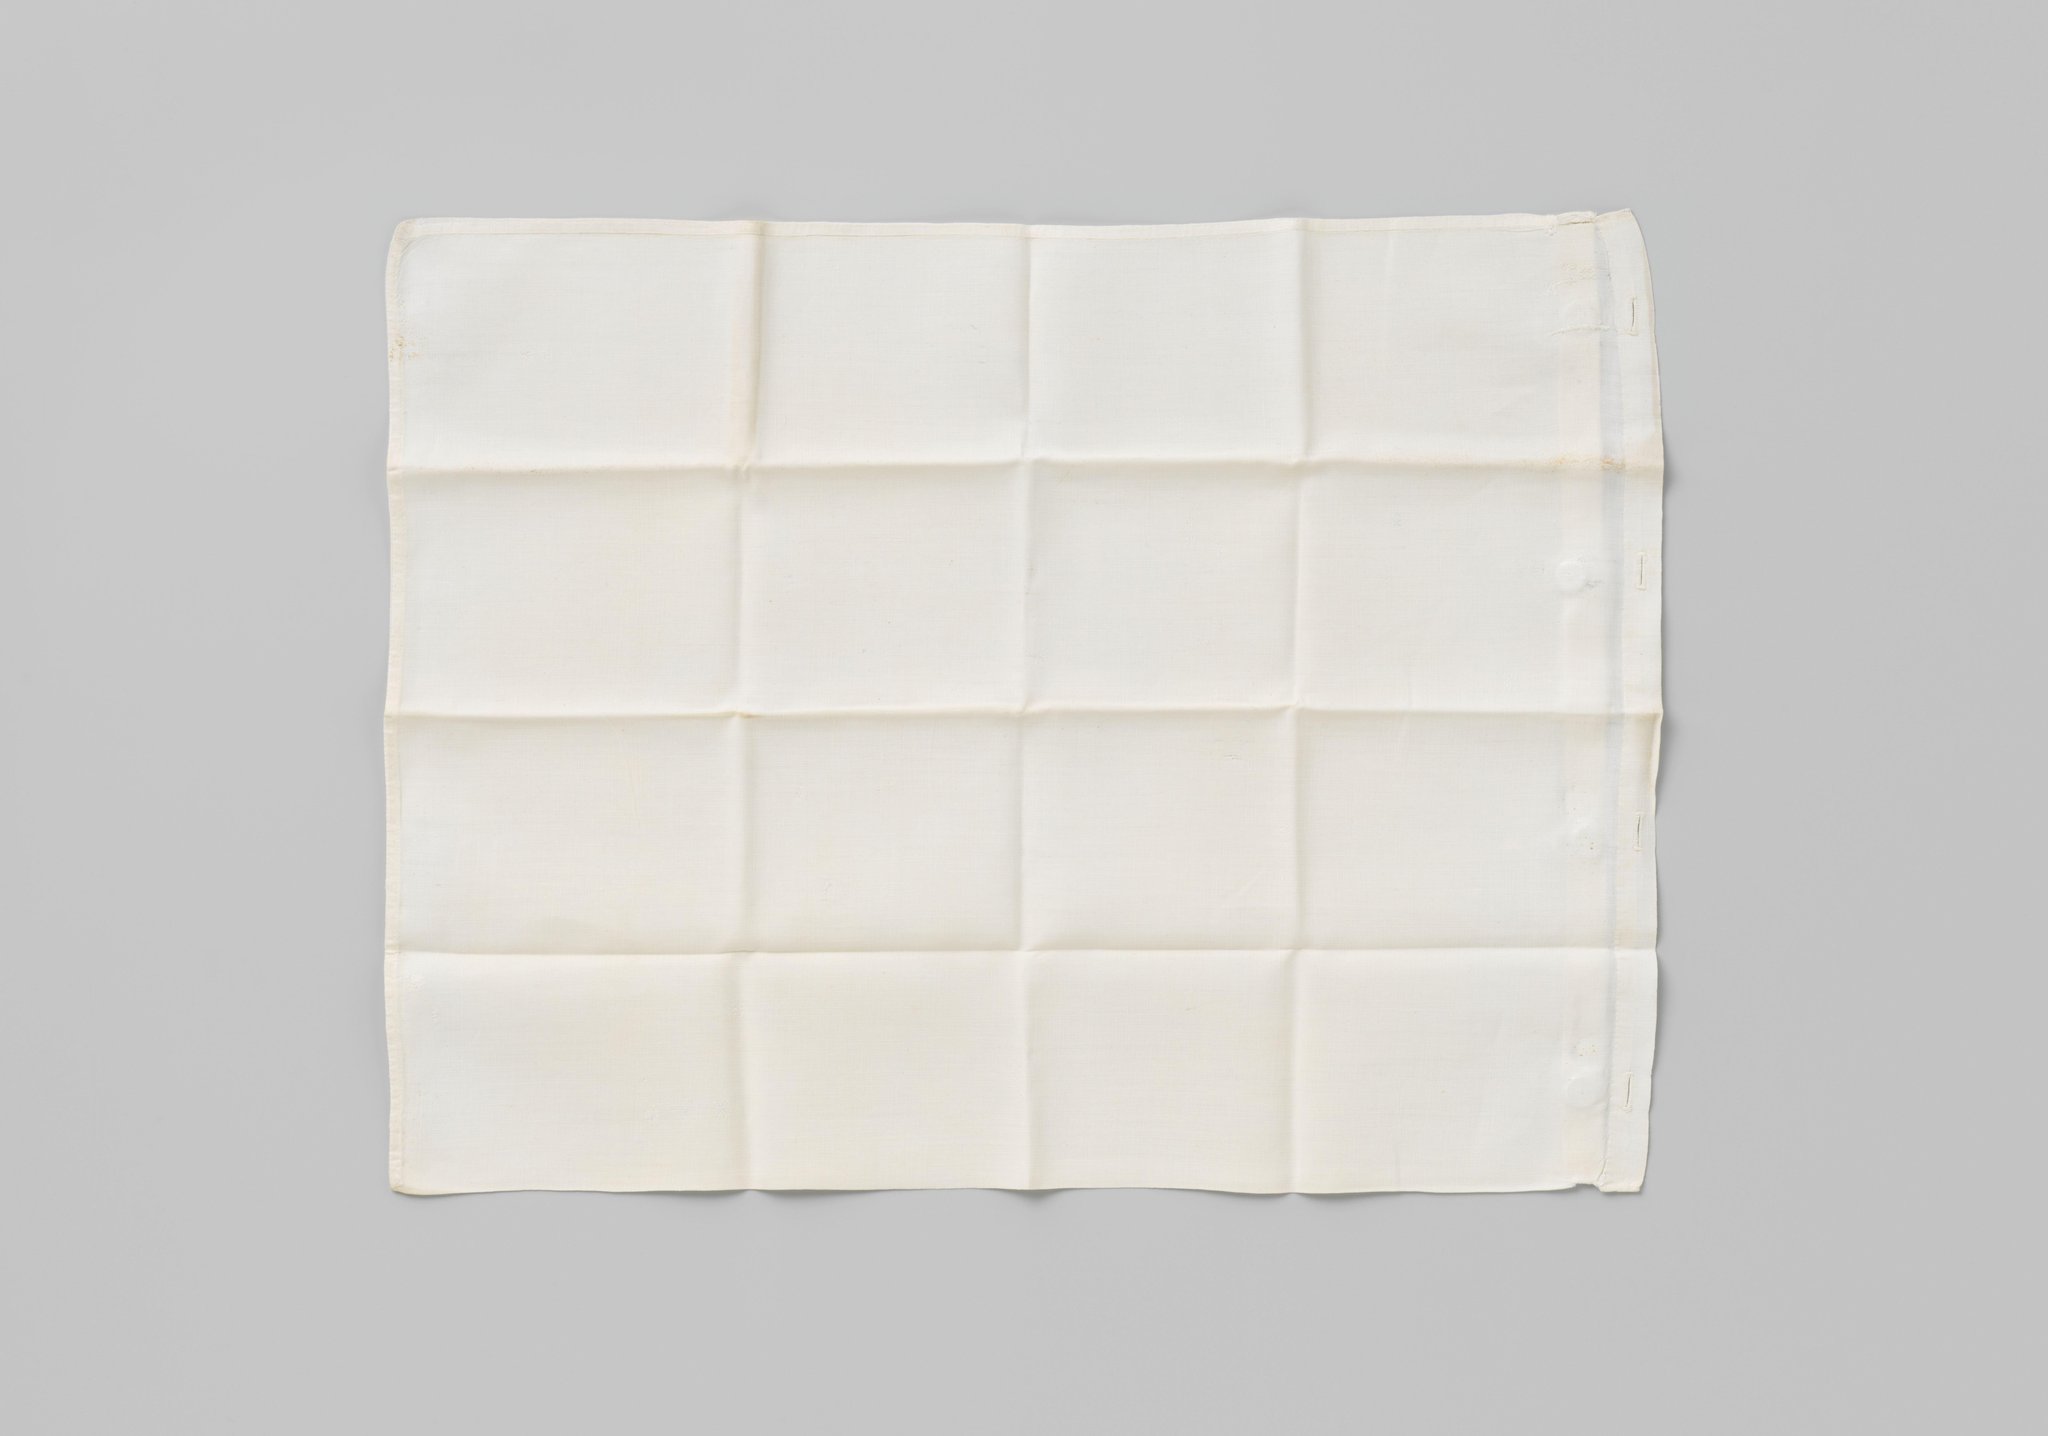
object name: lendensloop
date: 1875-1900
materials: linen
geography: northern netherlands